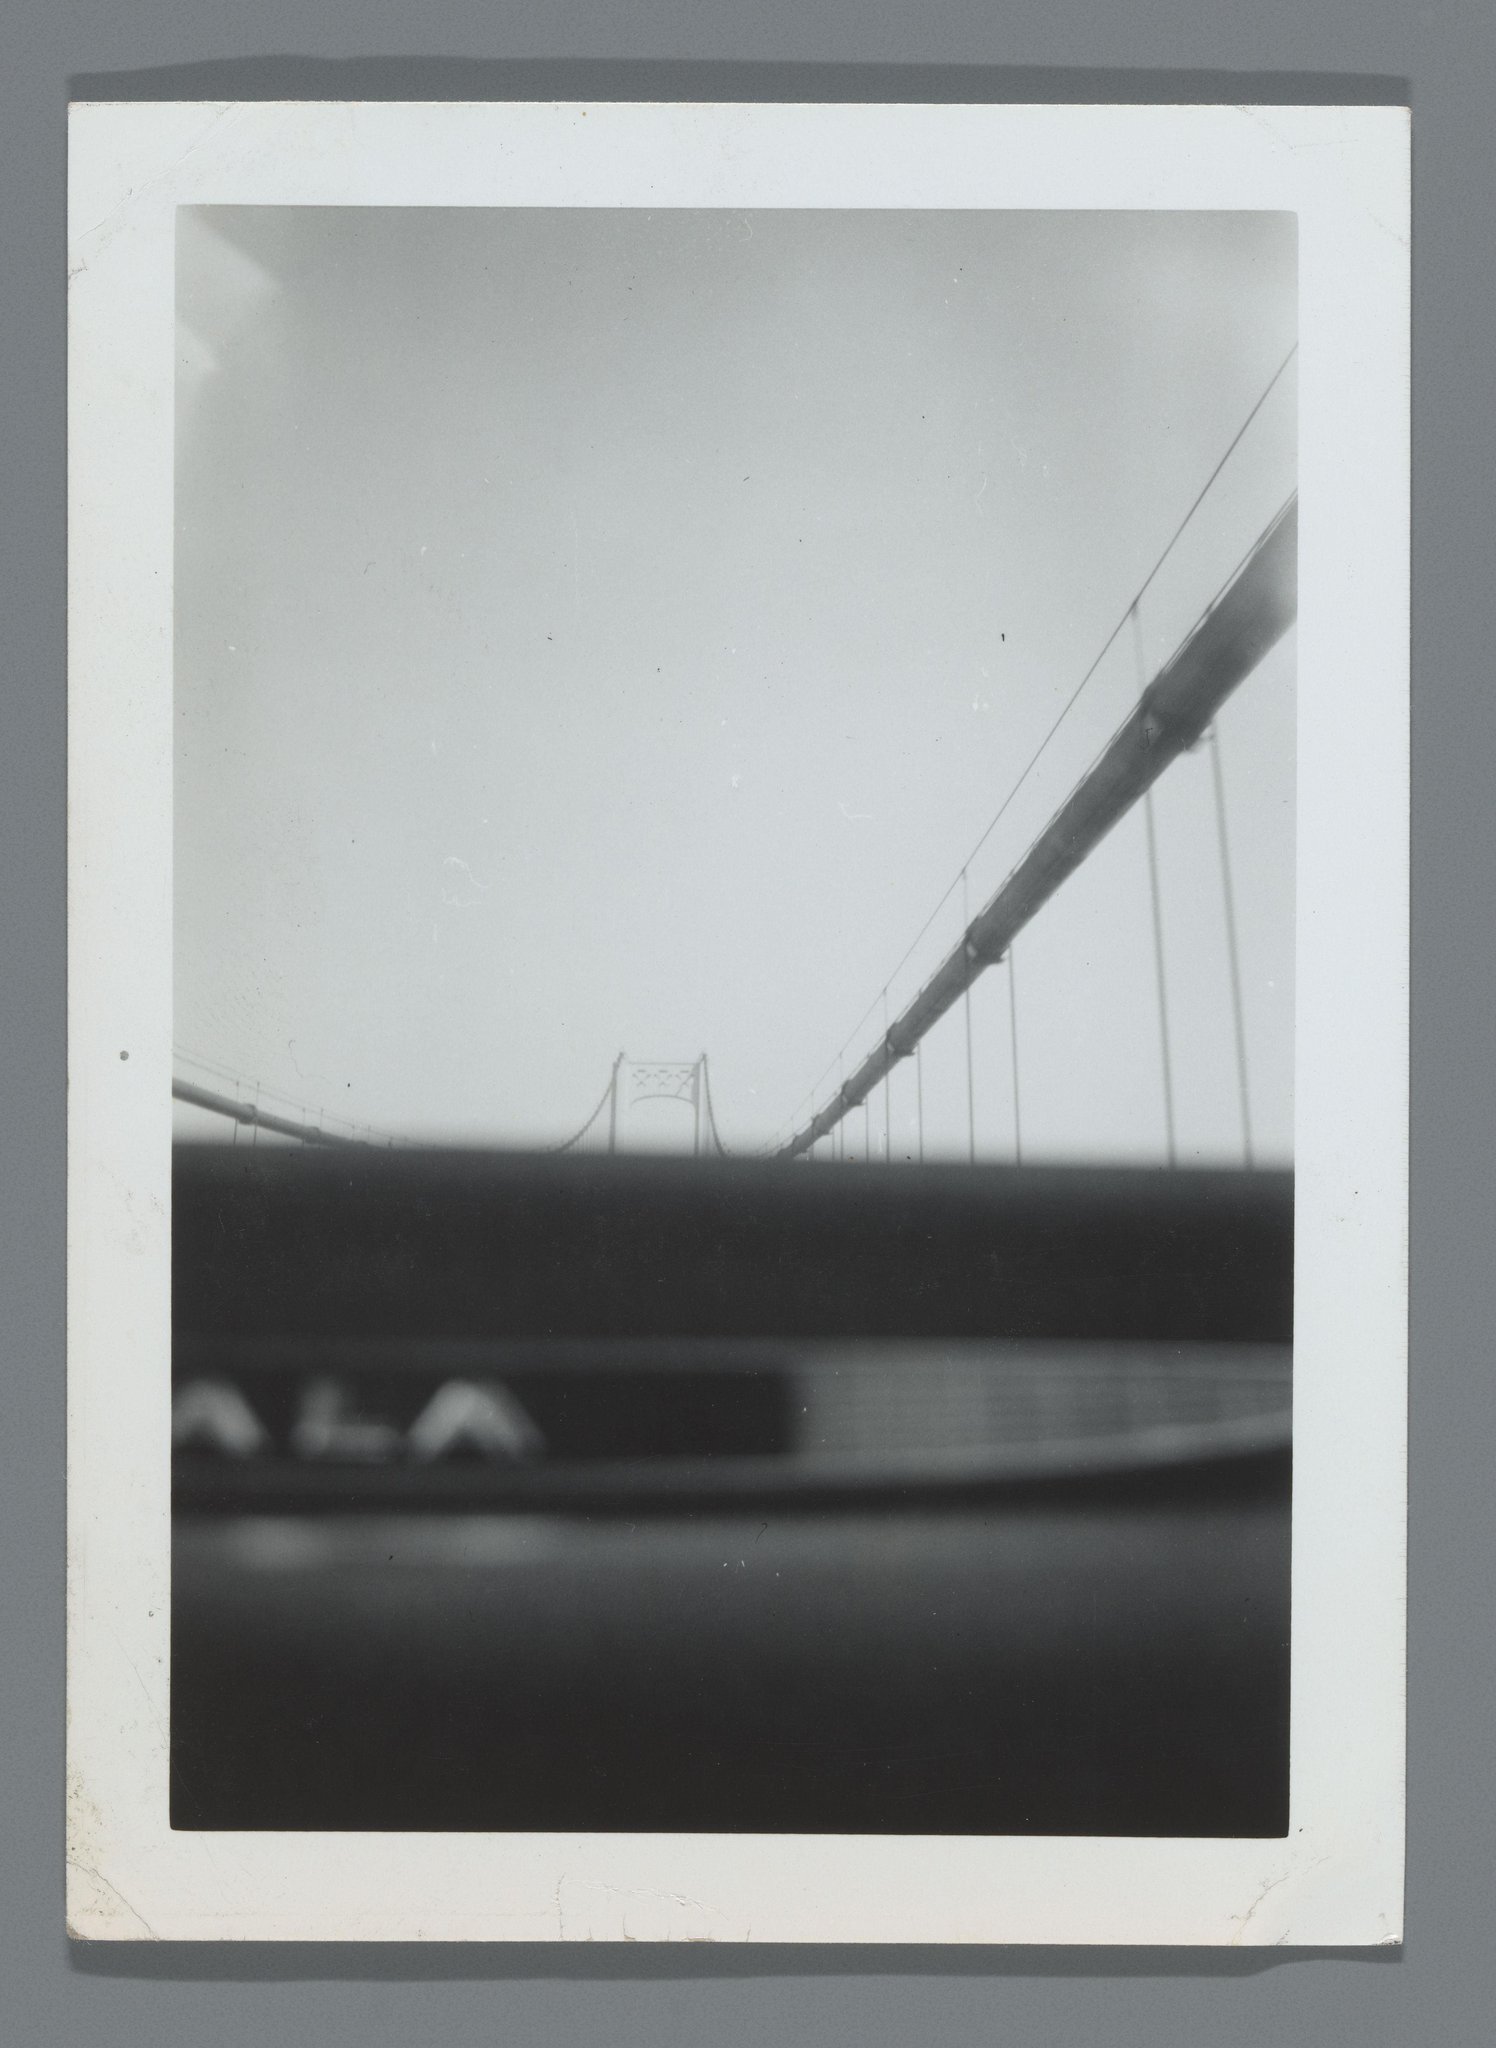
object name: photograph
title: Gezicht vanuit een rijdende auto, met zicht op een brug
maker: Anonymous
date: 1935-1950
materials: paper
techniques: gelatin silver print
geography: united states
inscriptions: inscription: ‘KODAK ® PAPER’